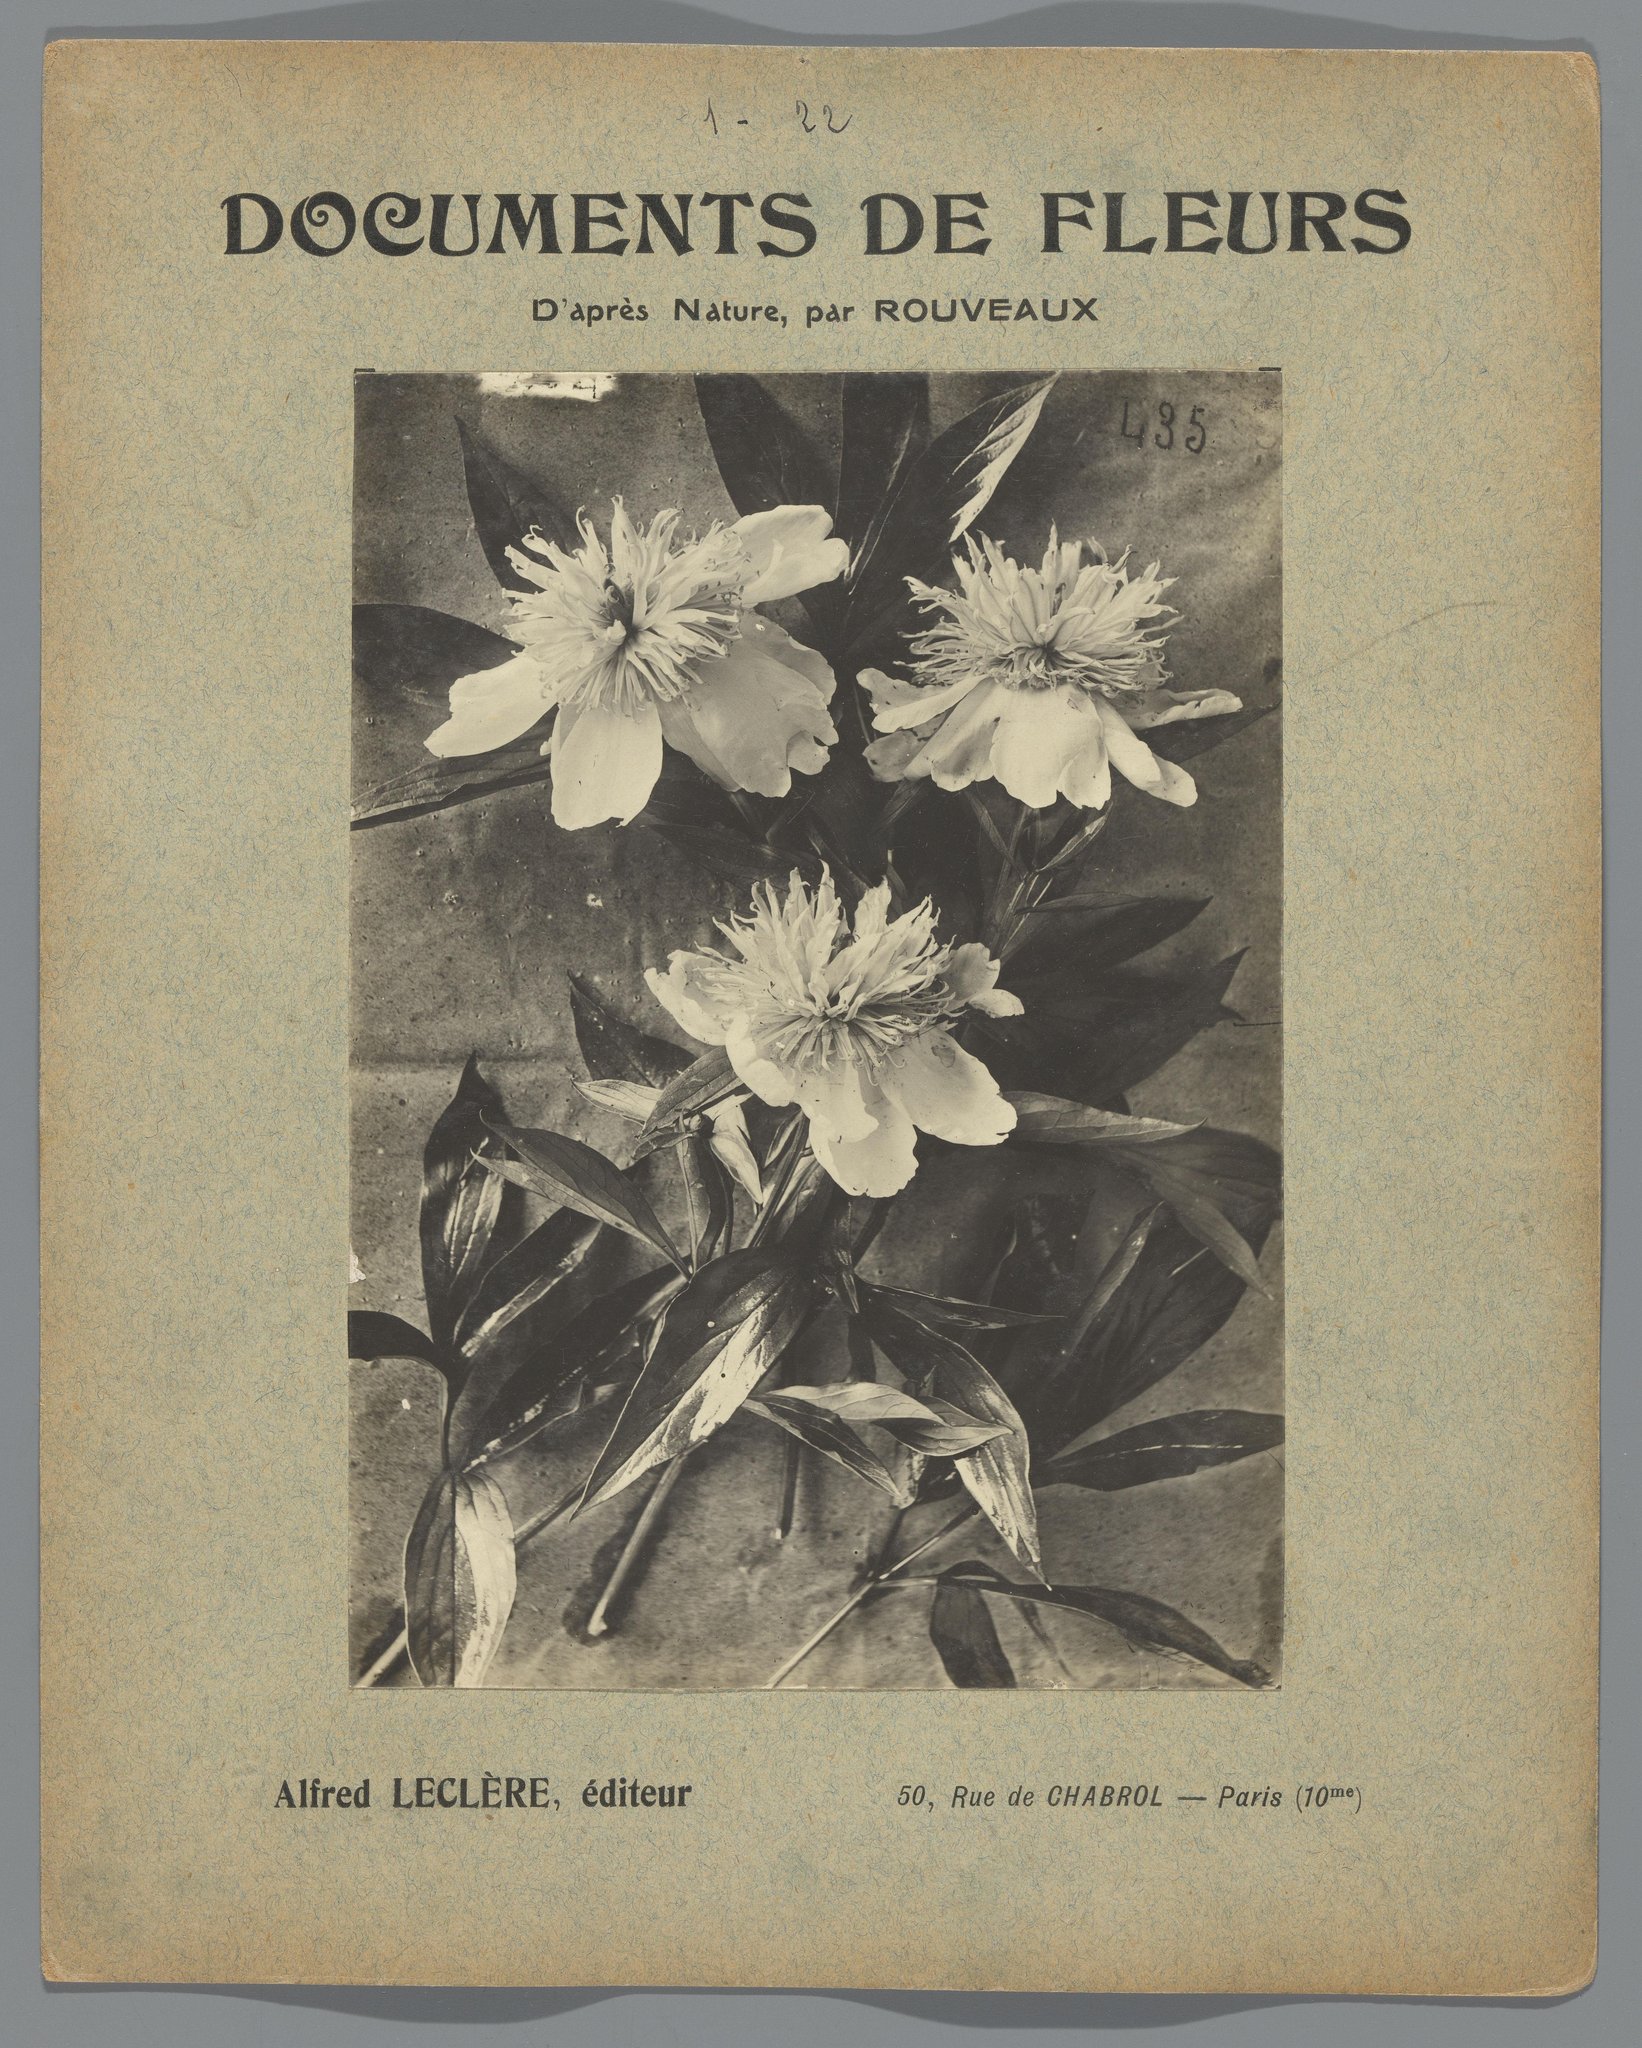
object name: photograph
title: Bloemstudie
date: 1895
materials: photographic support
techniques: gelatin silver print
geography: france